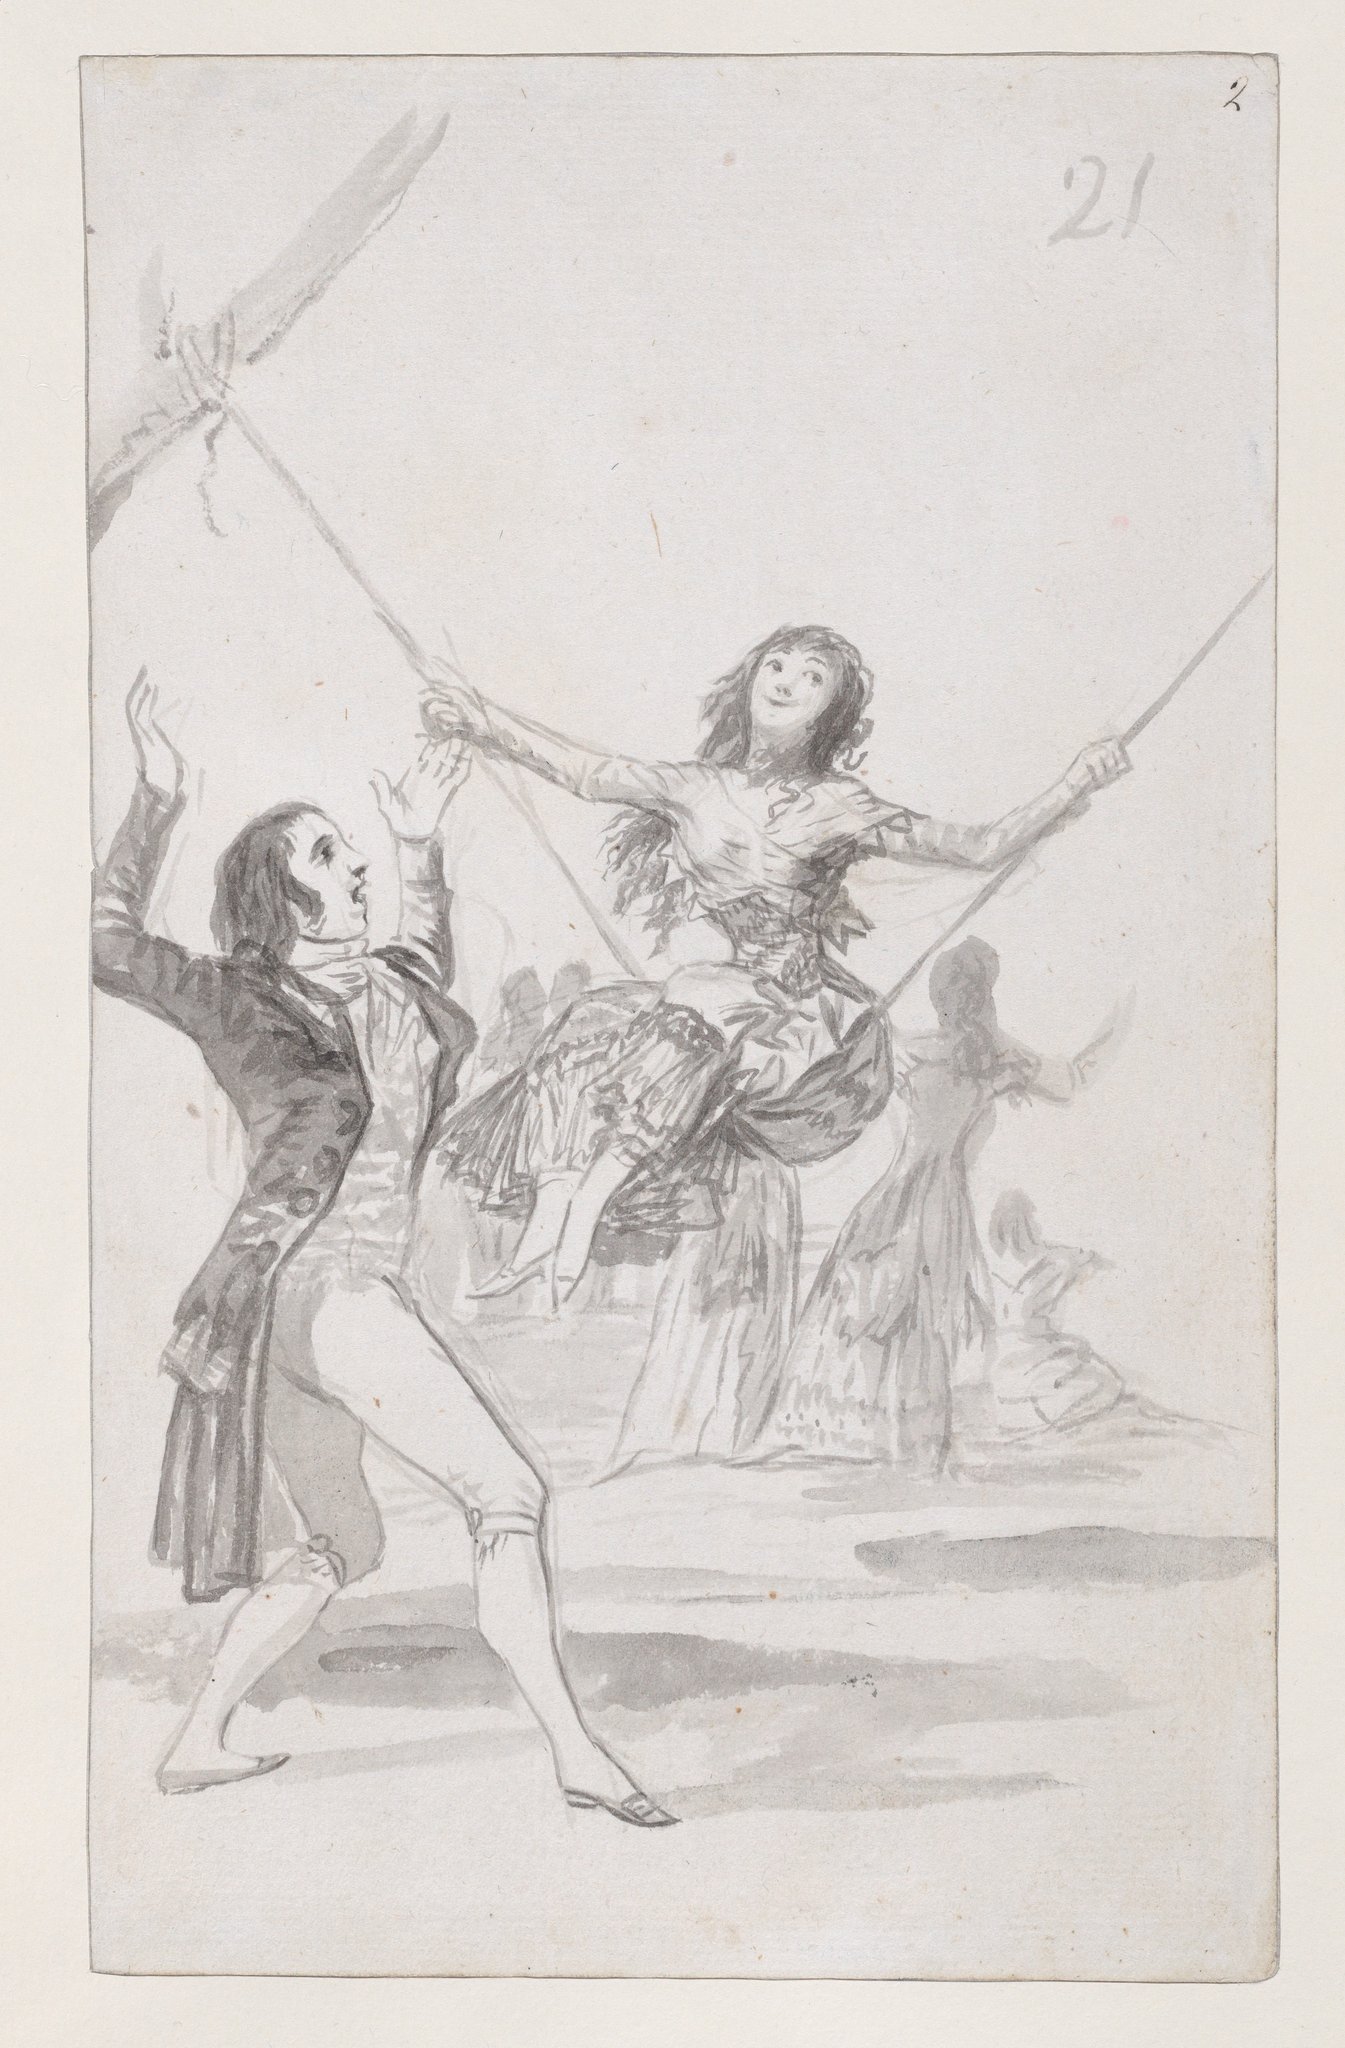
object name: drawing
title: Girl on a swing, a man with his arms raised; folio 21 (recto) from the Madrid Album "B"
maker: goya (francisco de goya y lucientes)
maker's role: artist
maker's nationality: spanish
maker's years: 1746-1828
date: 1795-1797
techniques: brush, wash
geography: spain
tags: girls,men